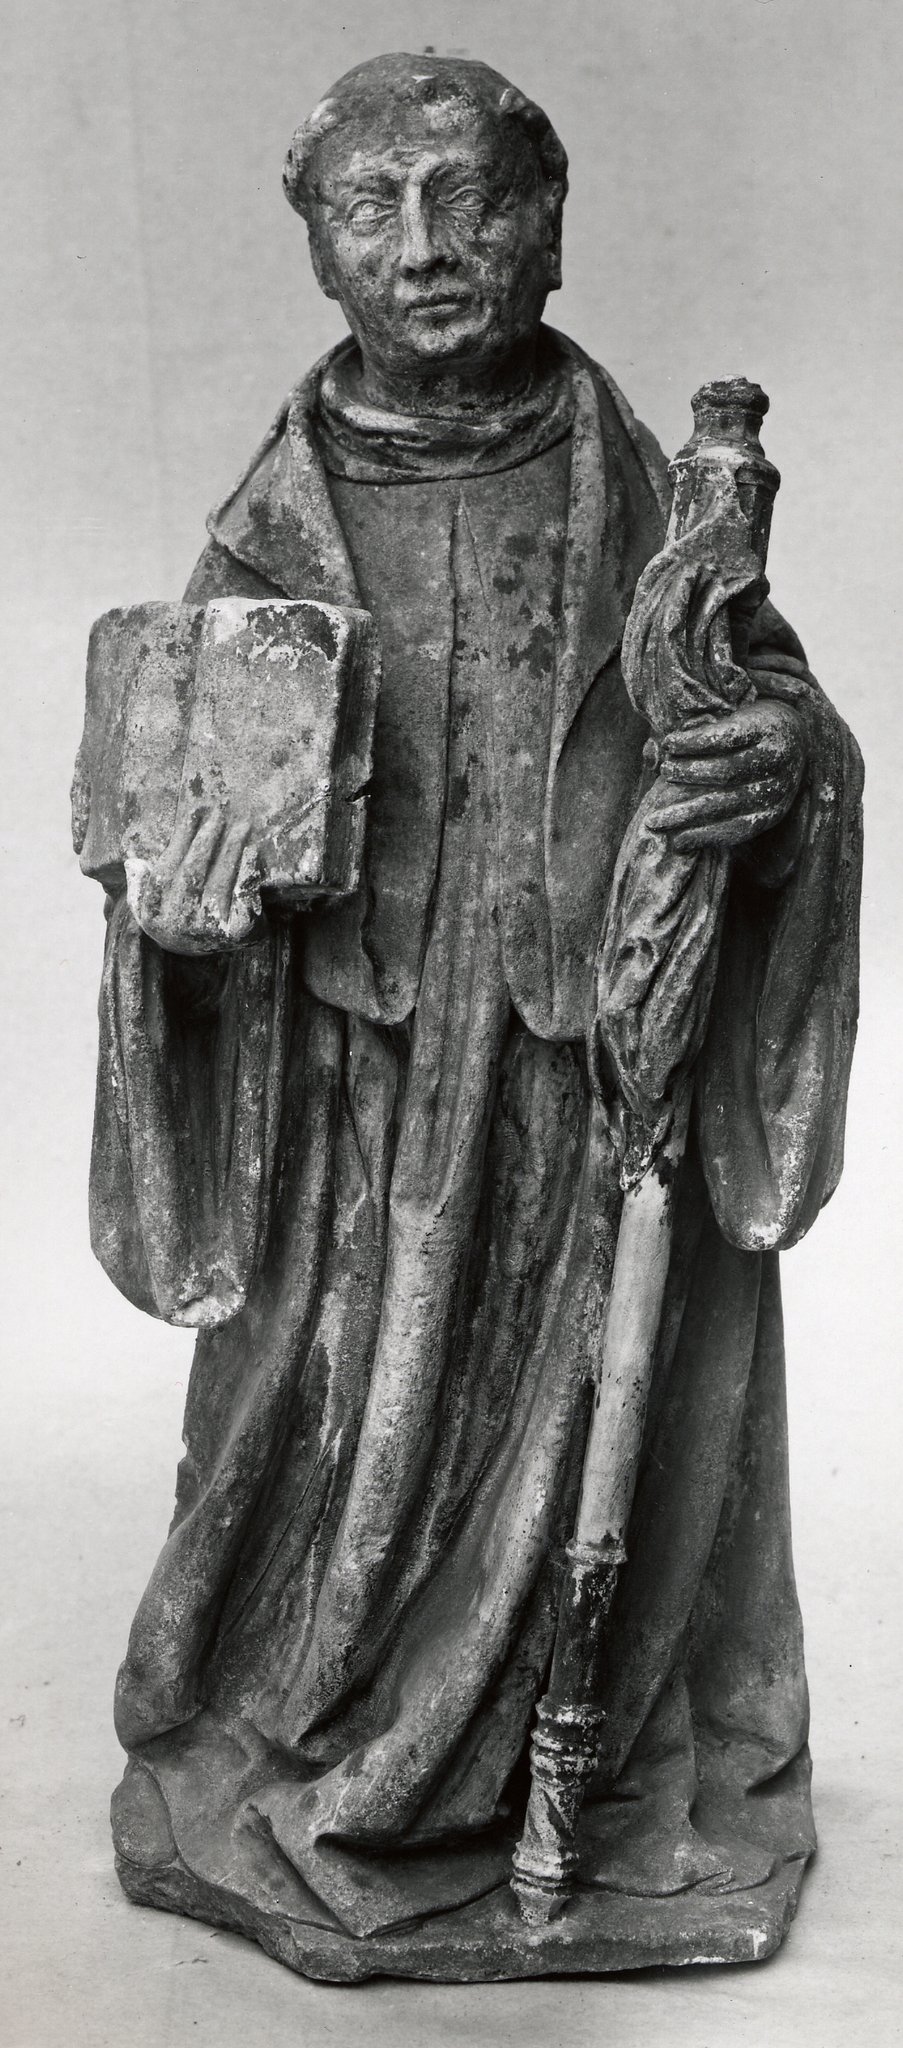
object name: statuette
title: Ecclesiastical Figure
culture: french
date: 1401-1500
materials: stone